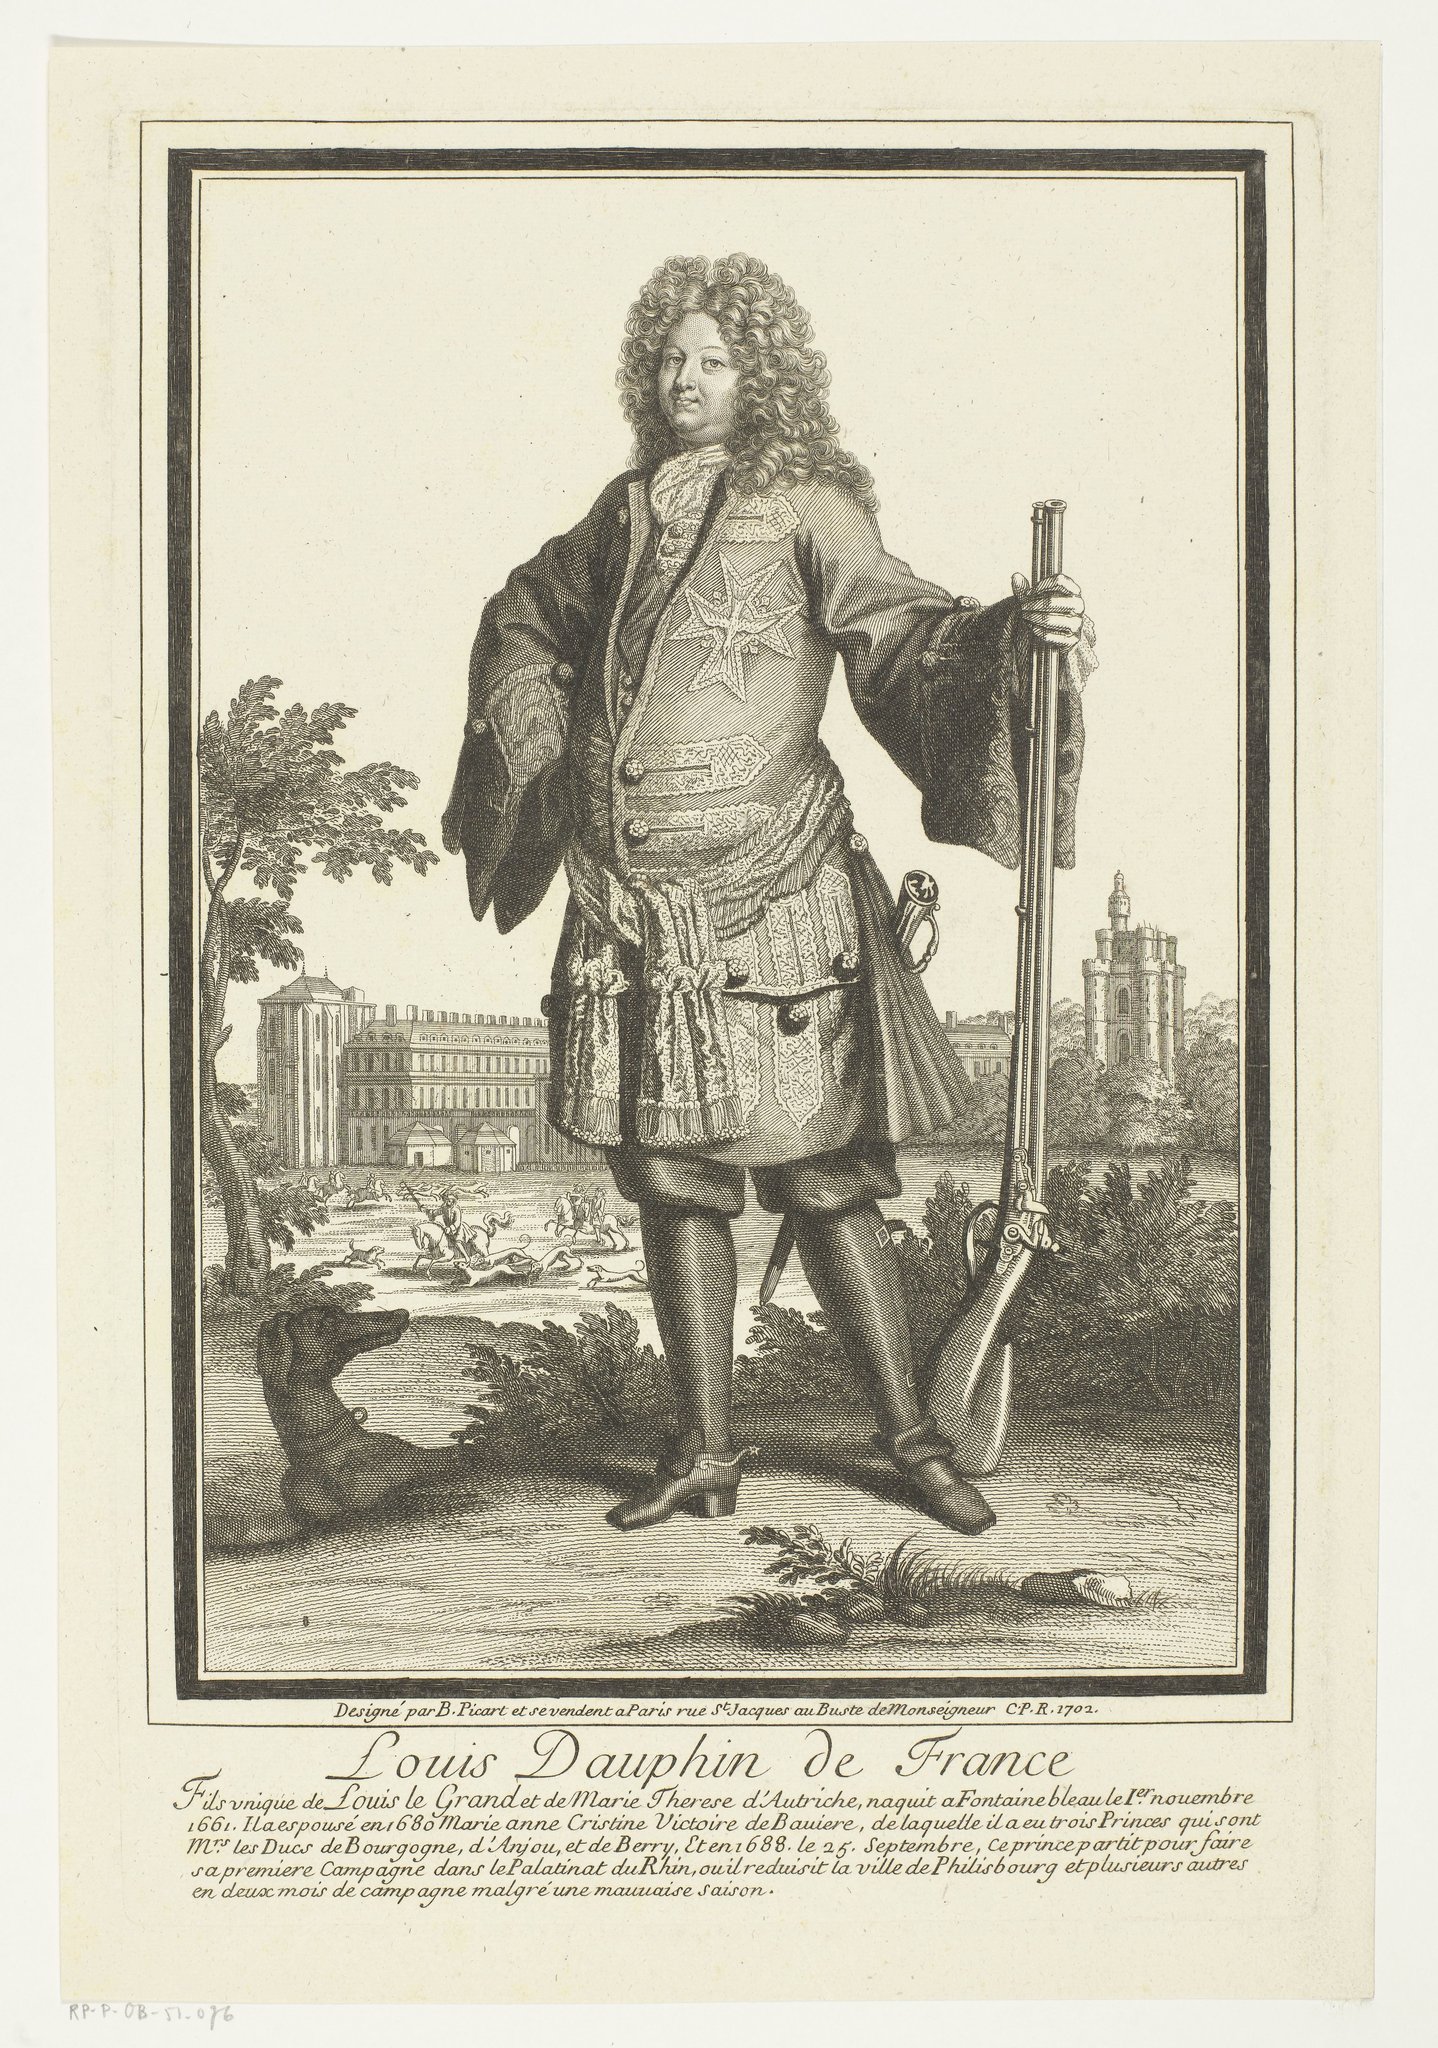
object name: costume print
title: Portret van Lodewijk, dauphin van Frankrijk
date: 1702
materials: paper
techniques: engraving, etching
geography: paris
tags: dauphin van frankrijk lodewijk, ensembles of pieces of clothing (hunting costume) (+ men's clothes), styles of hairdress (allonge), coat (justaucorps) (+ men's clothes), shoes, sandals (+ men's clothes), clothes, costume (+ men's clothes), firearms: rifle, knighthood order of the holy spirit, trousers, breeches, etc. (breeches) (+ men's clothes)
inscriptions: caption: ‘Fils unique de Louis le Grand et de Marie Therese d'Autriche....de prince partit pour faire sa premiere Campagne dans le Palatinat du Rhin, ou ik reduisit la ville de Philisbourg et plusieurs autres en deuc mois de campagne malgé une mauvaise saison.’, collector's mark: Lugt 2228, signature: ‘Designé par B. Picart’, date: ‘1702’, address: ‘et se vendent a Paris rue St. jacques au Buste de Monseigneur’, title: ‘Louis Dauphin de France’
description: Portret van Lodewijk, dauphin van Frankrijk (ook bekend als le Grand Dauphin). Hij draagt een jachttenue en leunt op zijn geweer. Op de achtergrond kasteel Fontainebleau en een jachtpartij. In de marge een zesregelig onderschrift in het Frans.